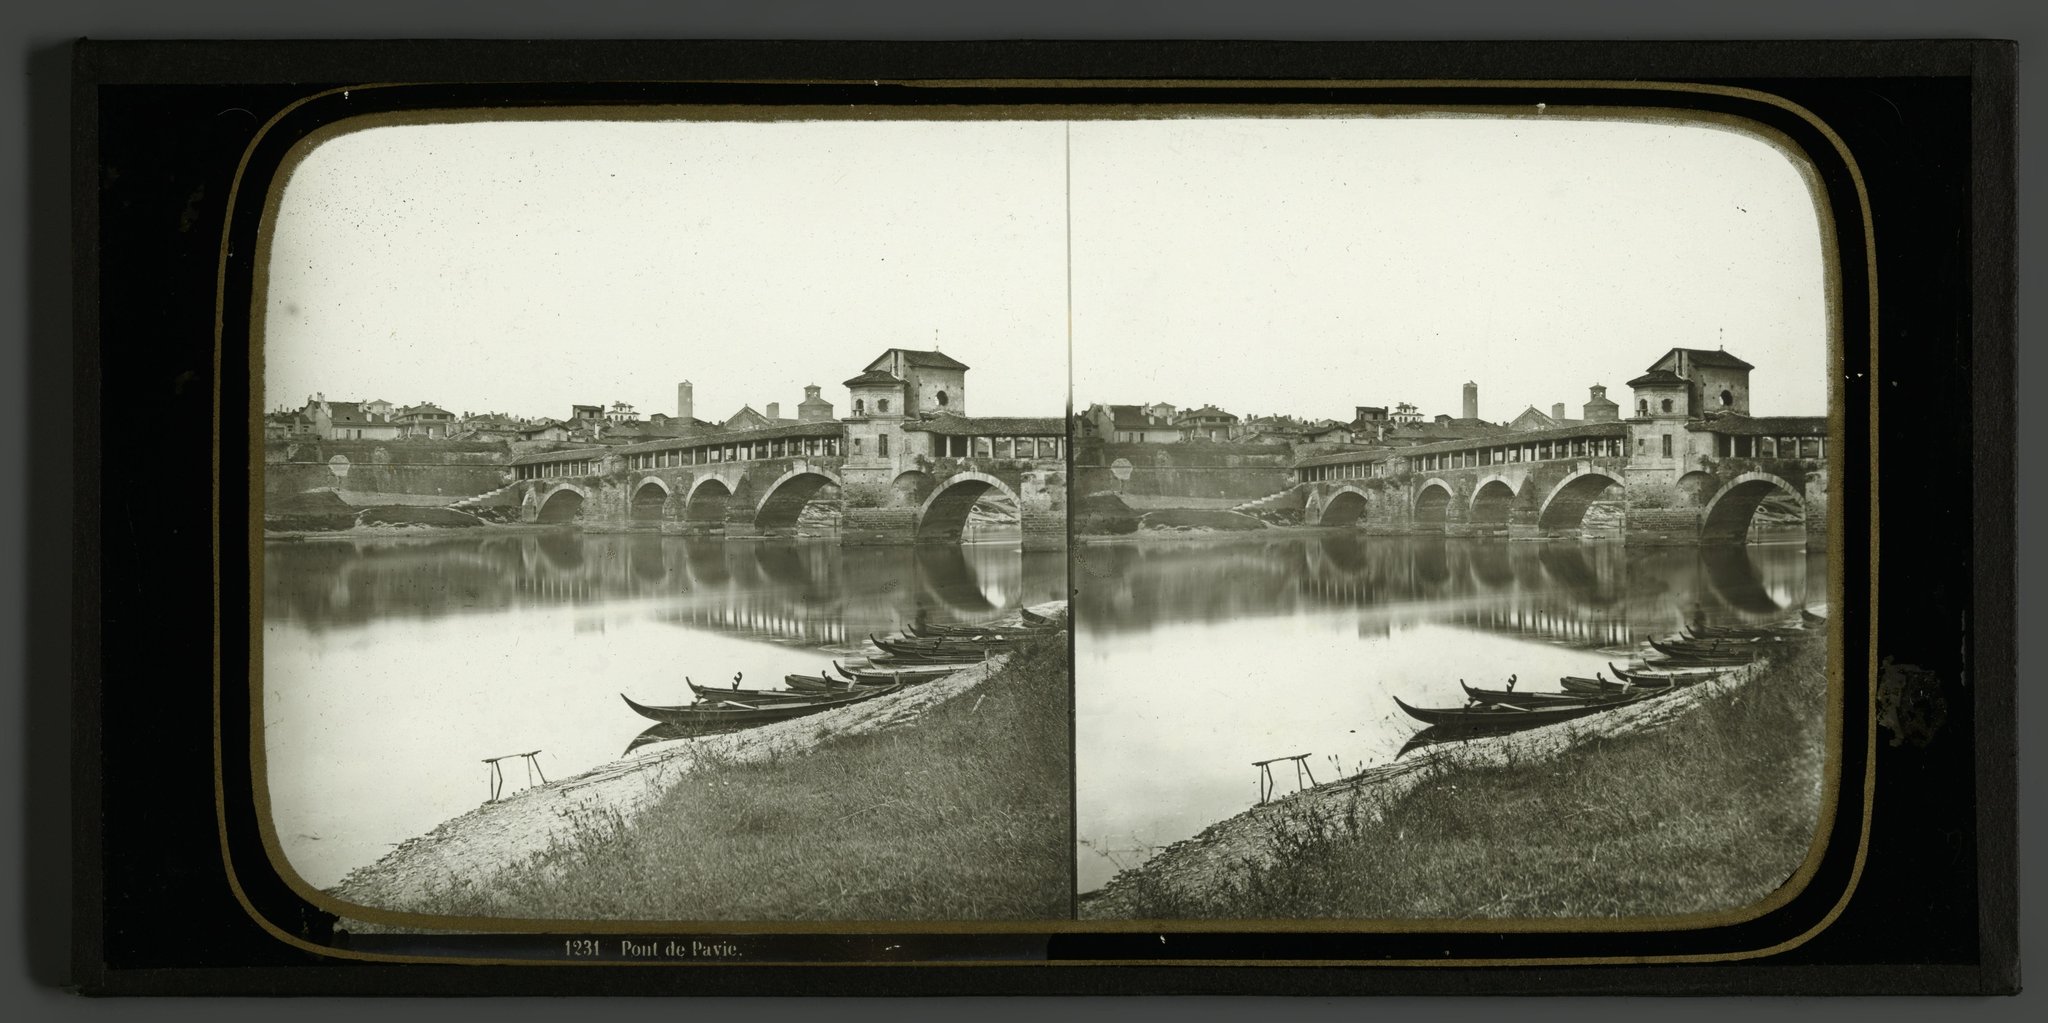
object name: stereoscopic photograph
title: Pont de Pavie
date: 1860-1870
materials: glass, paper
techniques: slide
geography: pavia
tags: bridge with structure, i.e. cover or buildings, canals, waters (in city)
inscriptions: number: ‘1231’